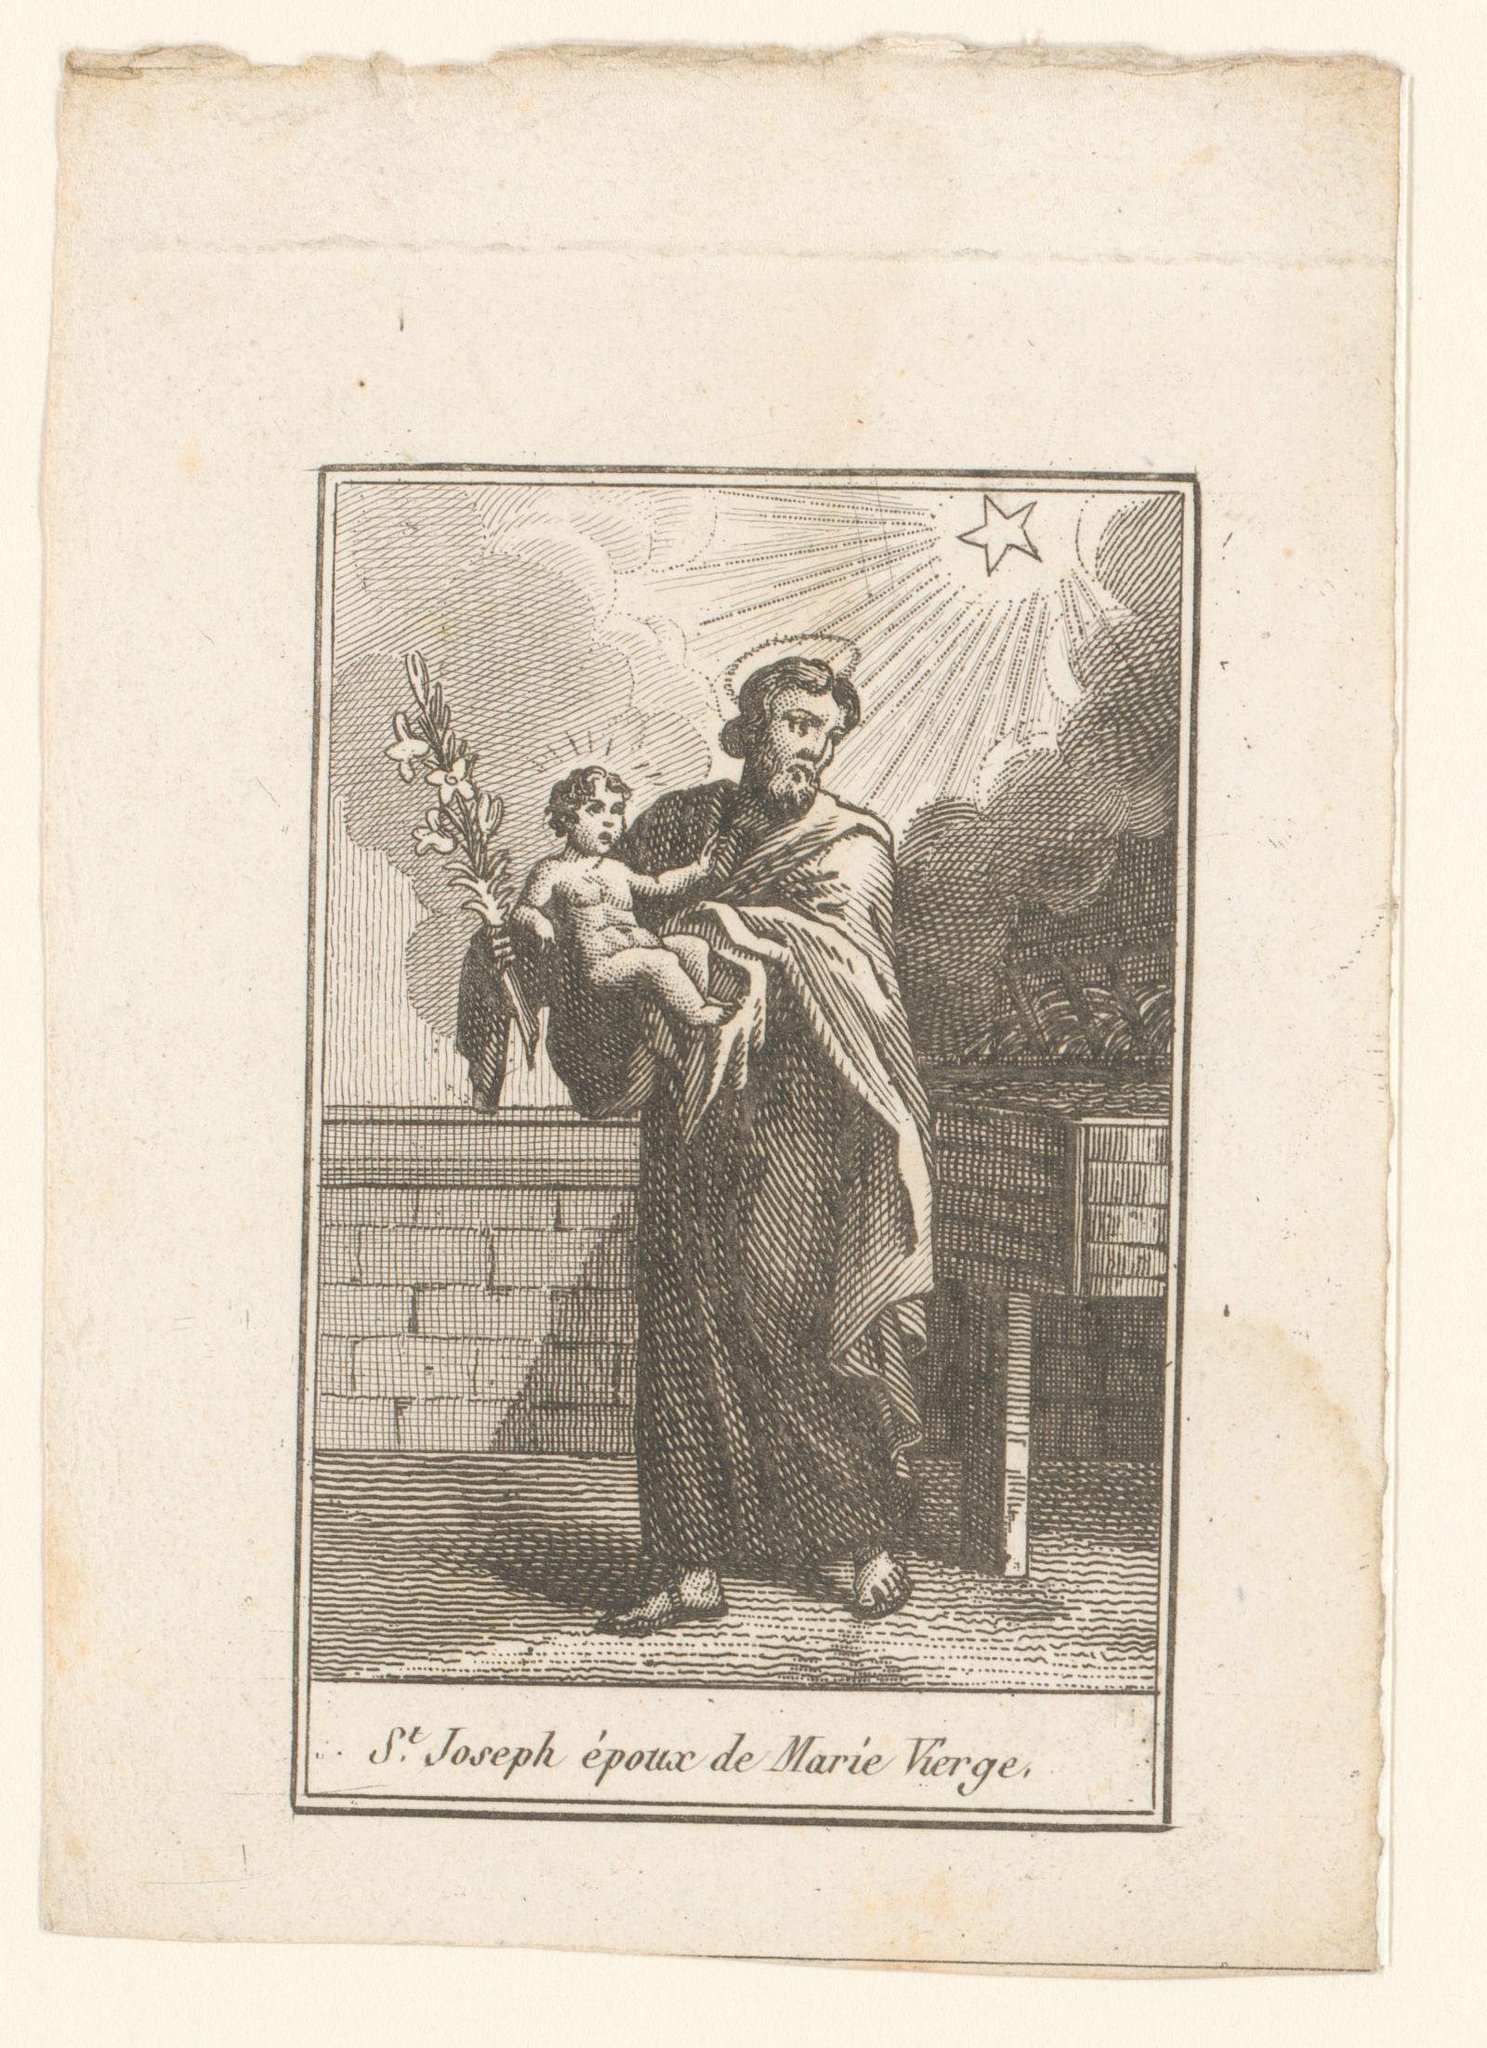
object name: print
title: Heilige Jozef met Christuskind en lelietak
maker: Anonymous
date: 1700-1800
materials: paper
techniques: etching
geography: france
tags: the foster-father of christ, joseph of nazareth, husband of mary; possible attributes: flowering rod or wand, lily, carpenter's tools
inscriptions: collector's mark: Lugt 2228